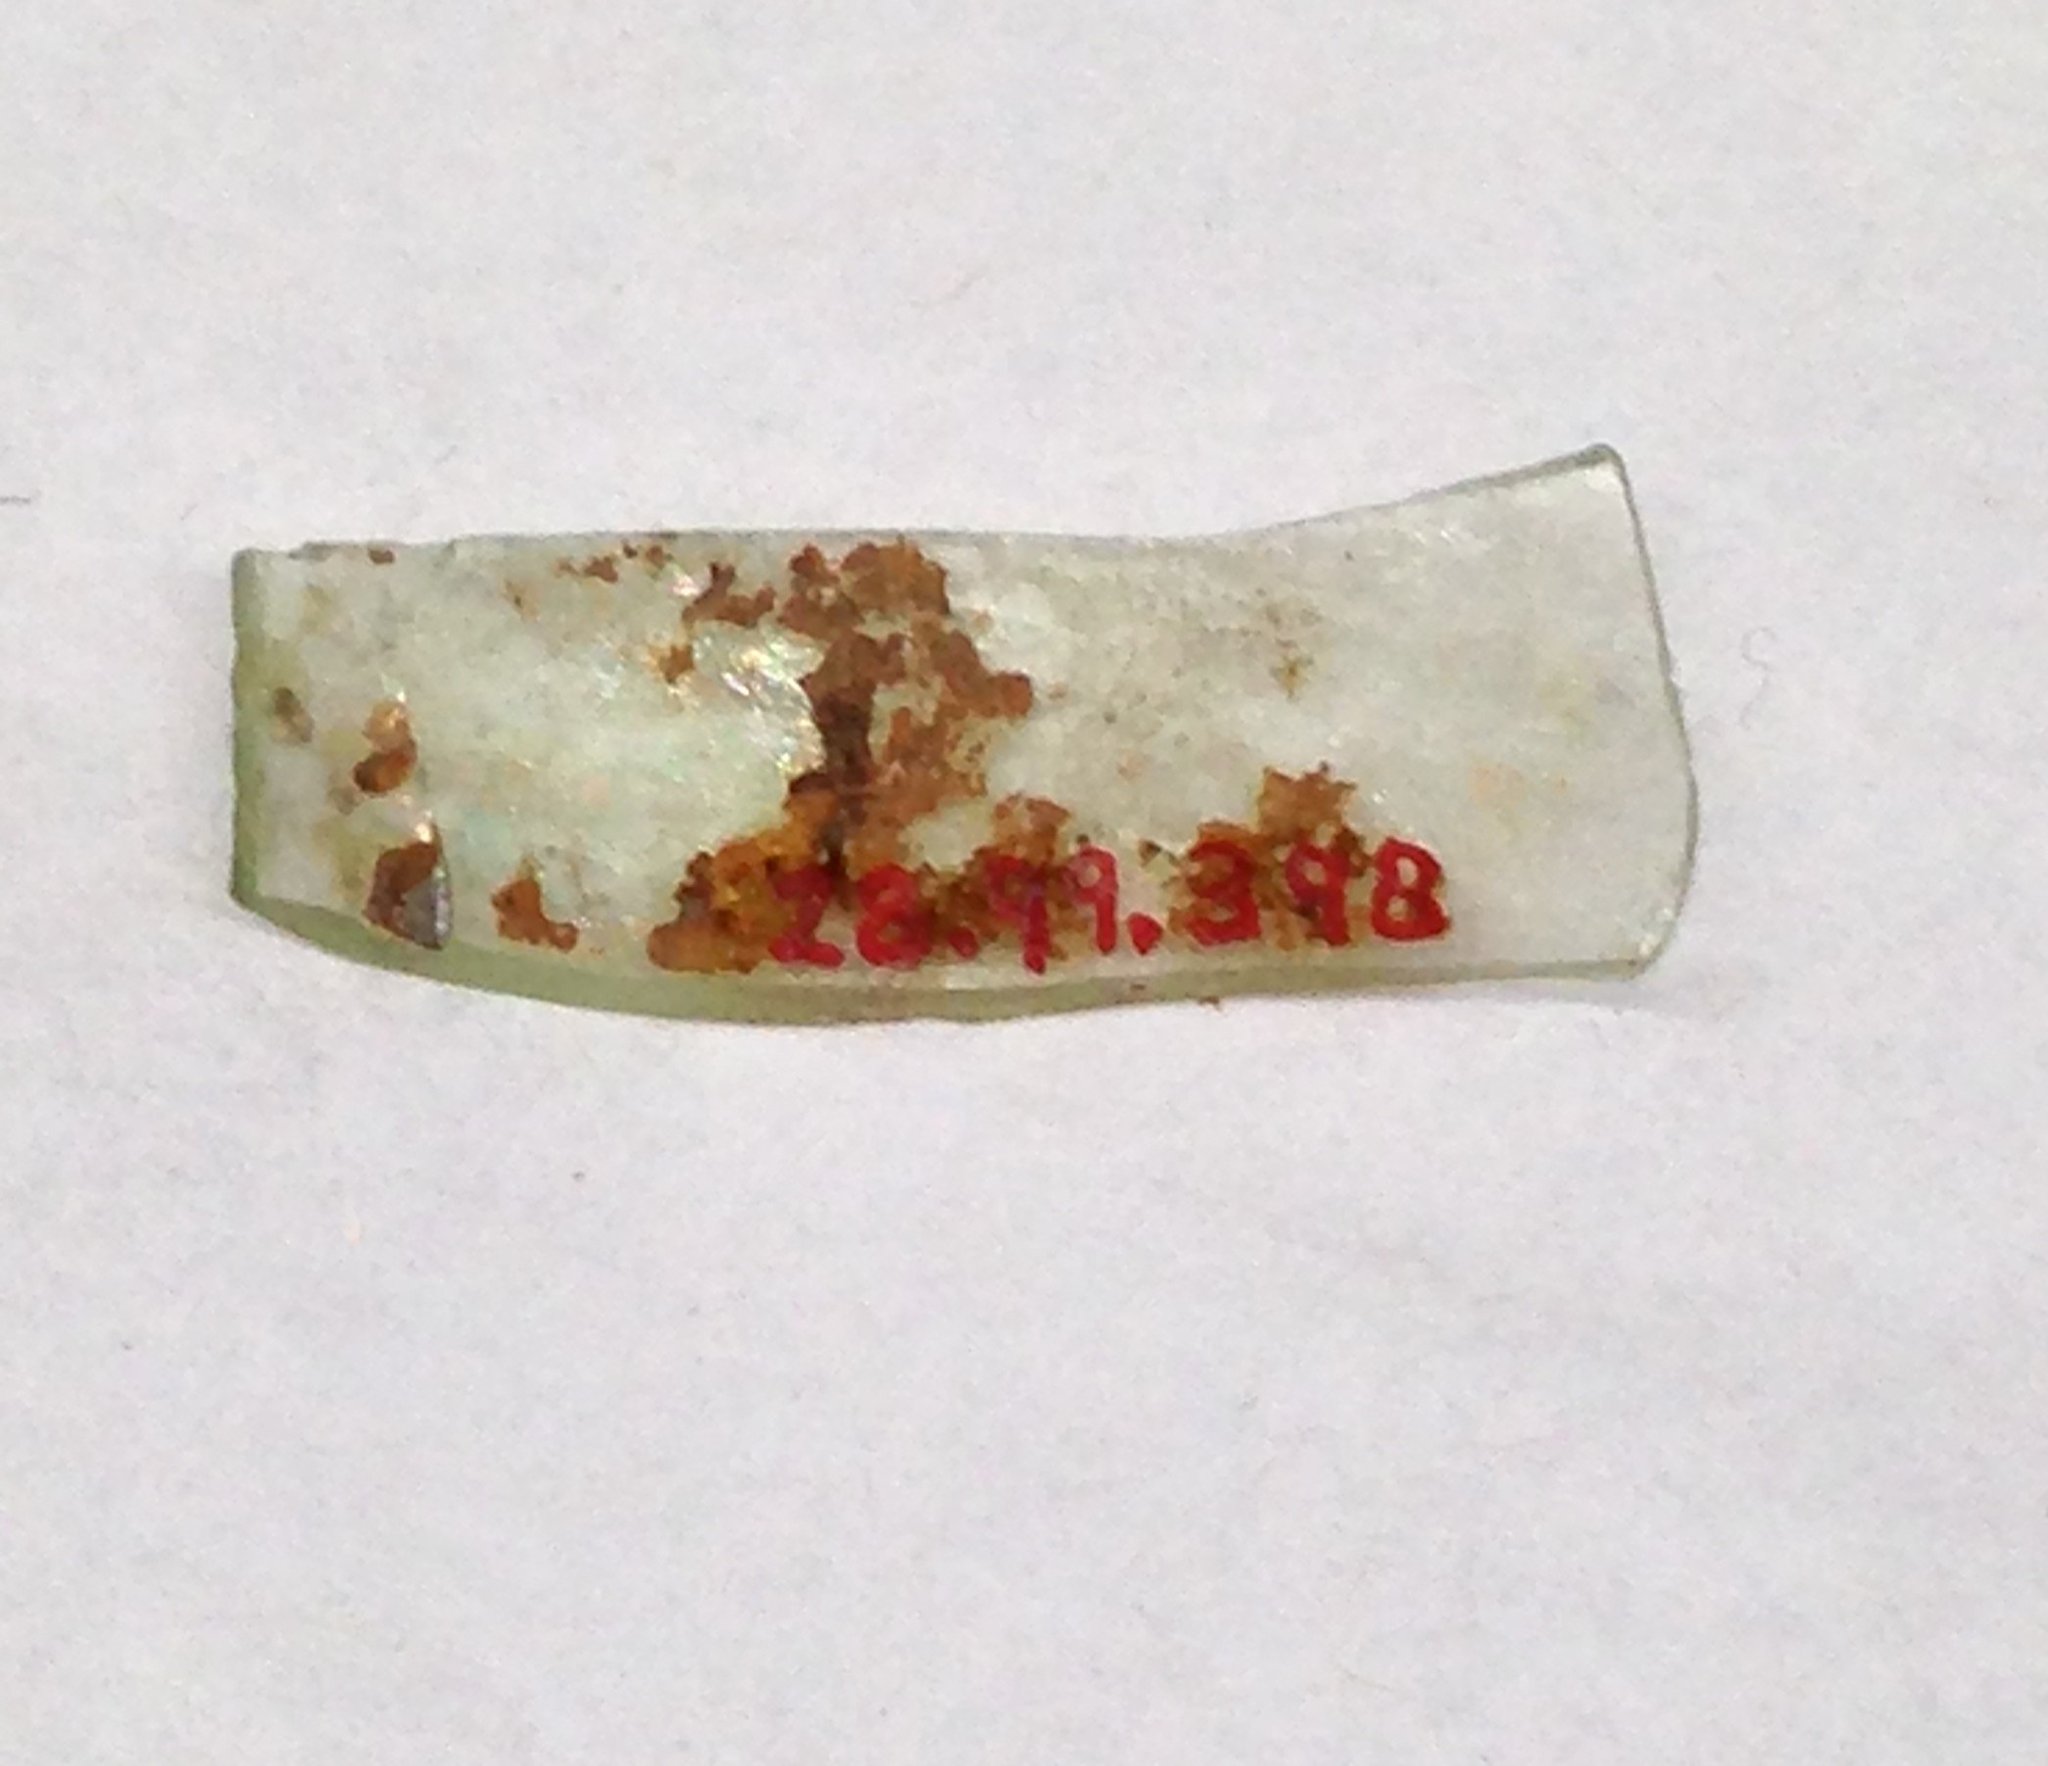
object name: fragment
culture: european or middle eastern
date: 1150-1250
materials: ceramic, glass